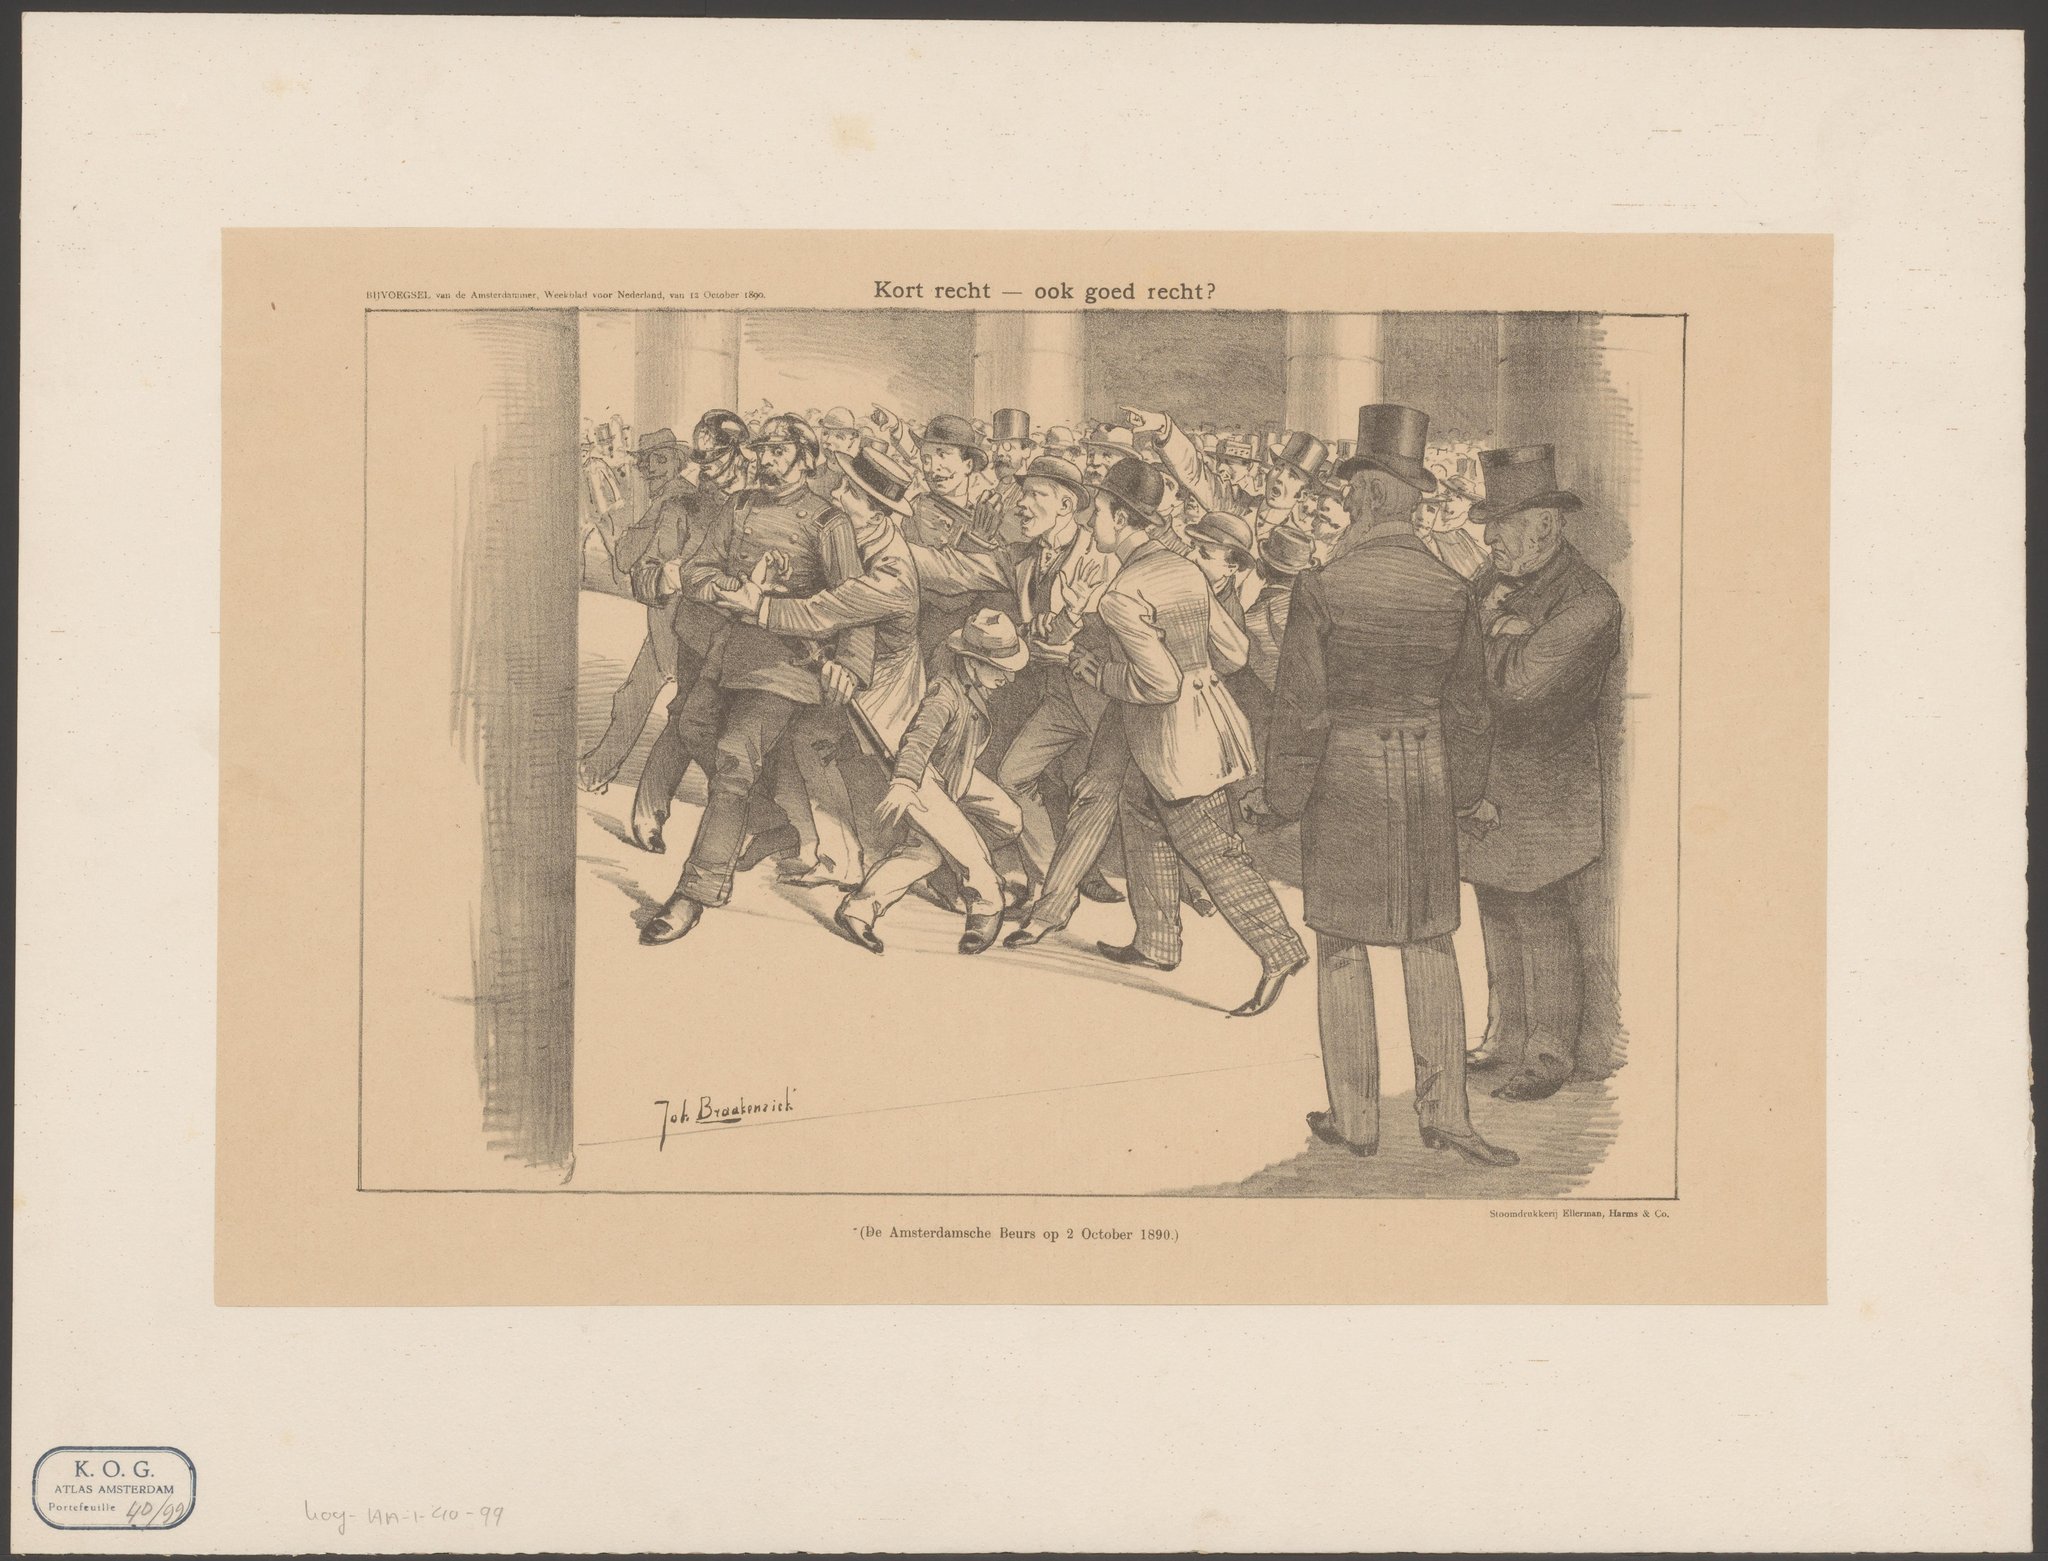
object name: cartoon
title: Kort recht - ook goed recht?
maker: johan braakensiek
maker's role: draughtsman, print maker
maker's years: 1858-1940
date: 1890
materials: paper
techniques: letterpress printing, lithograph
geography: netherlands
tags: speculation in trade and finance, stock-jobbery, stock exchange, stock-market, policeman, constable, political caricatures and satires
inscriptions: collector's mark: Lugt 1641b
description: Op de Amsterdamse Beurs kijken twee handelaren toe hoe twee politieagenten een massa boze beleggers of speculanten in toom proberen te houden. Onderwerpsrubriek binnen de Atlas Amsterdam: Handel en Zeevaart: Hulpbeurs op de Dam en Beurs (Dam).